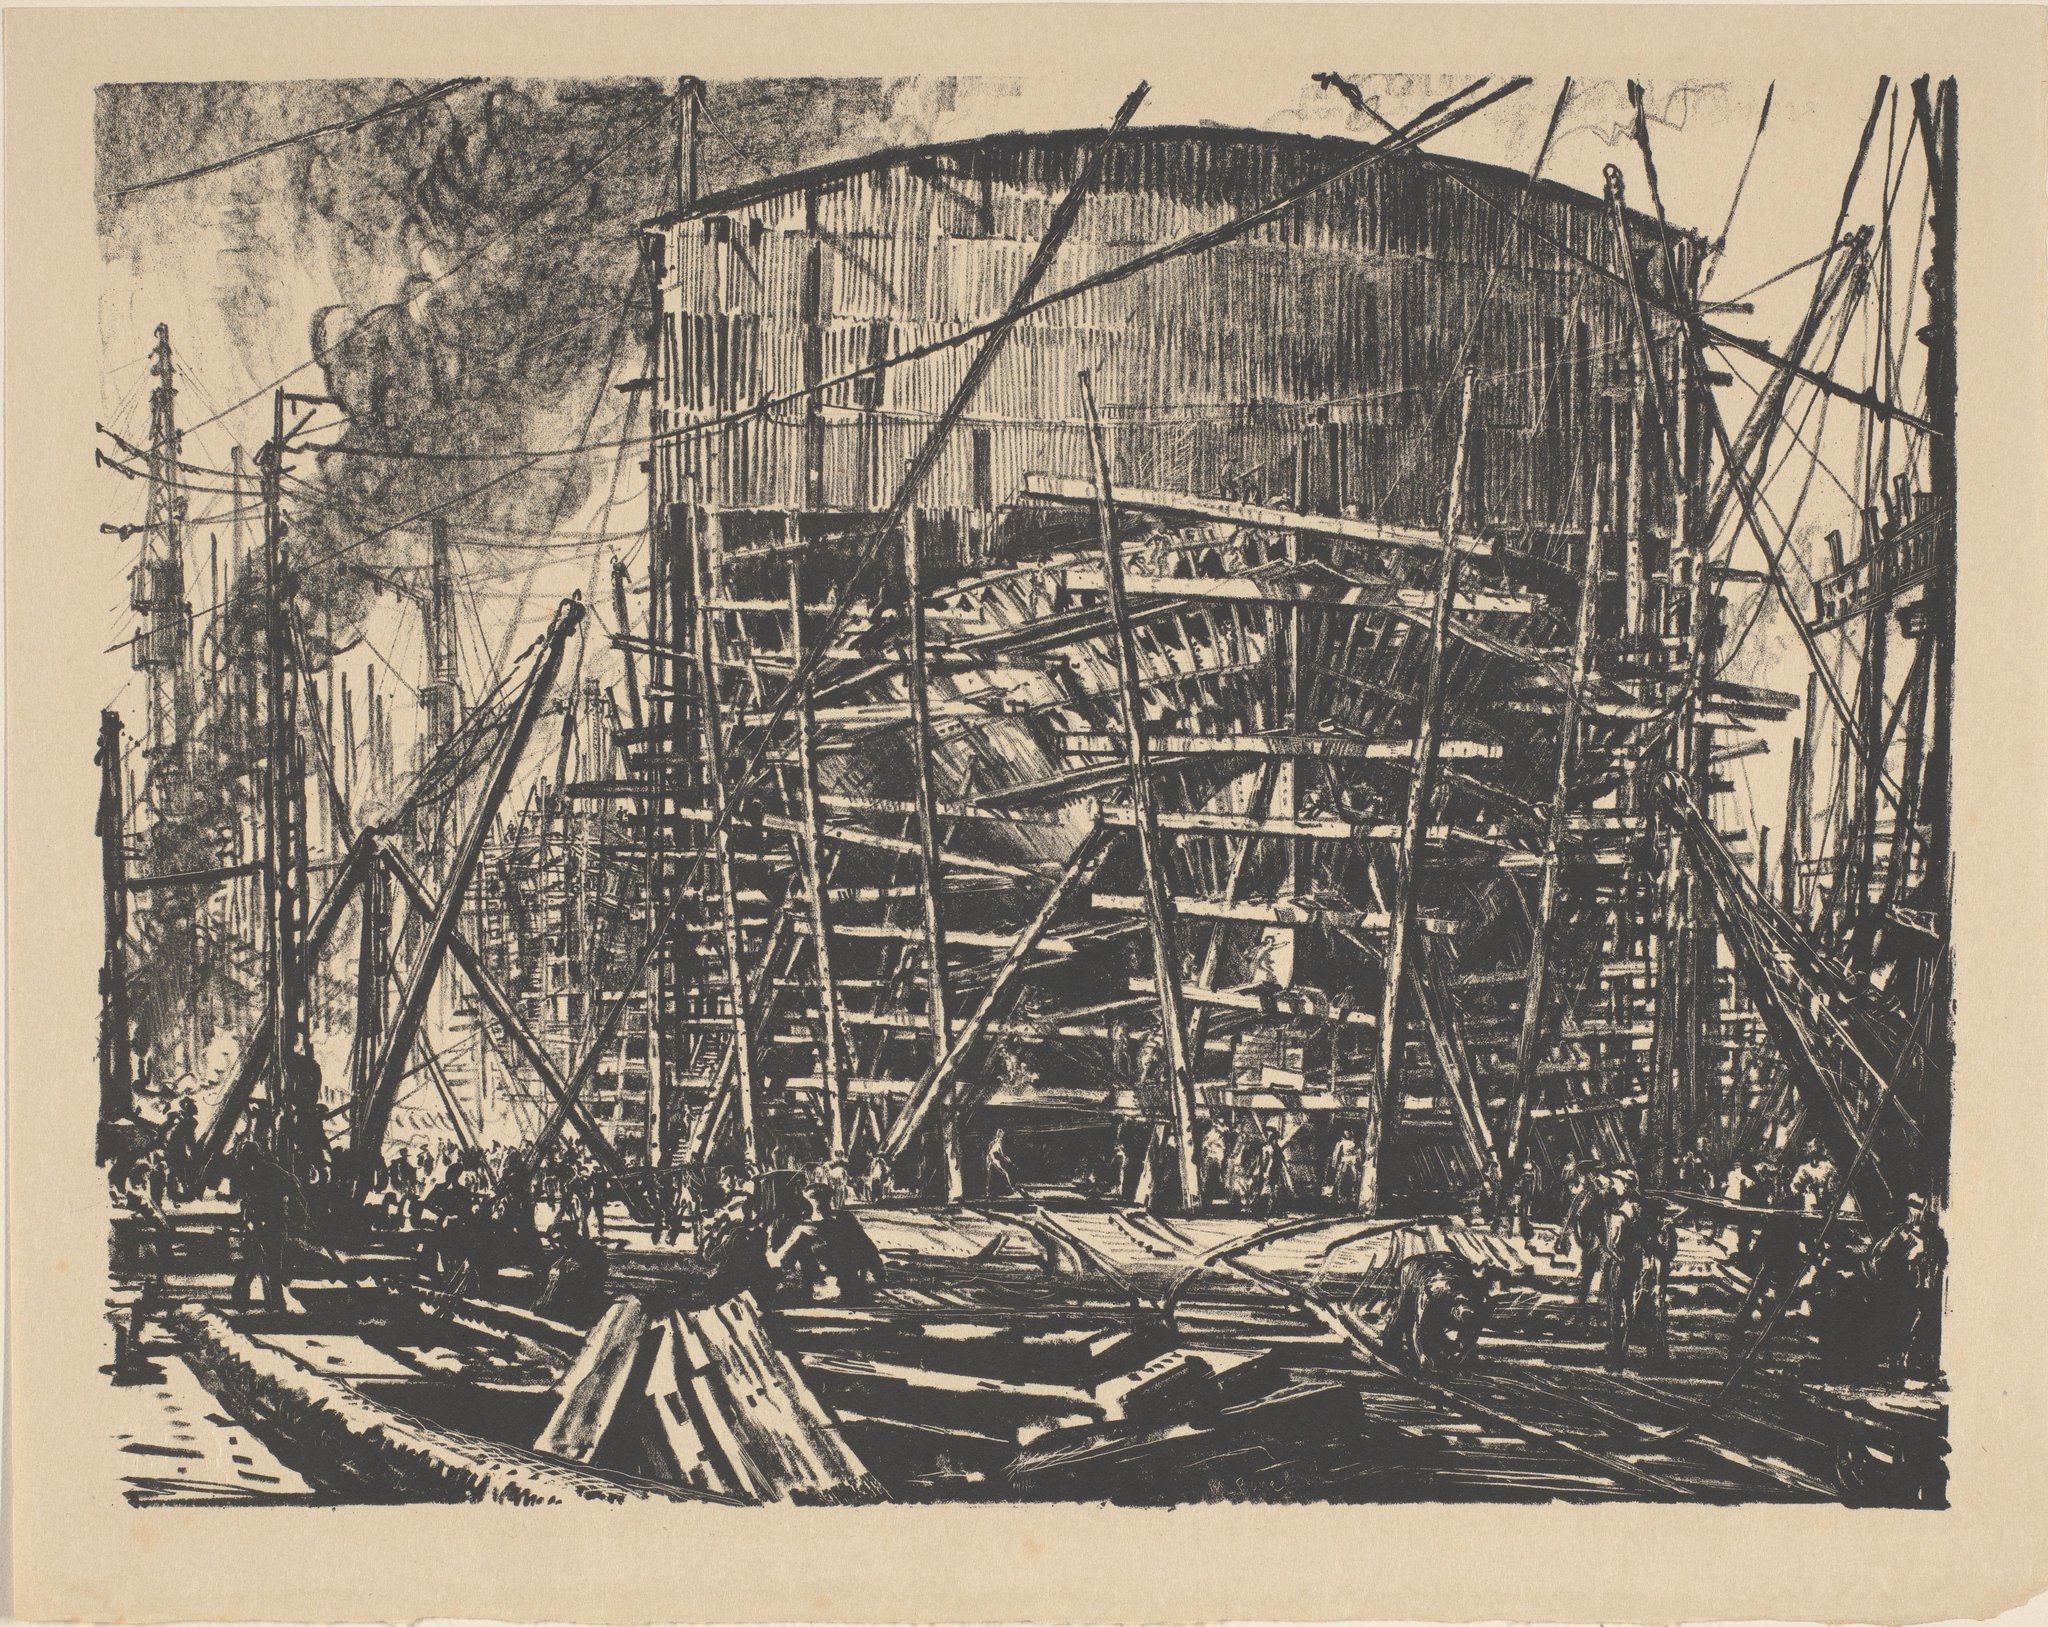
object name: print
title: Grote Oorlog: de inspanningen en idealen van Groot-Brittannië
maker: muirhead bone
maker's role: artist, print maker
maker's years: 1876-1953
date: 1916-1917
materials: paper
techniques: lithograph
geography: england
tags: ships (in general), harbour equipment, building-site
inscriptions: watermark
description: Deze prent behoort tot de reeks 'Building Ships' binnen de serie 'The Great War: Britain’s Efforts and Ideals'.